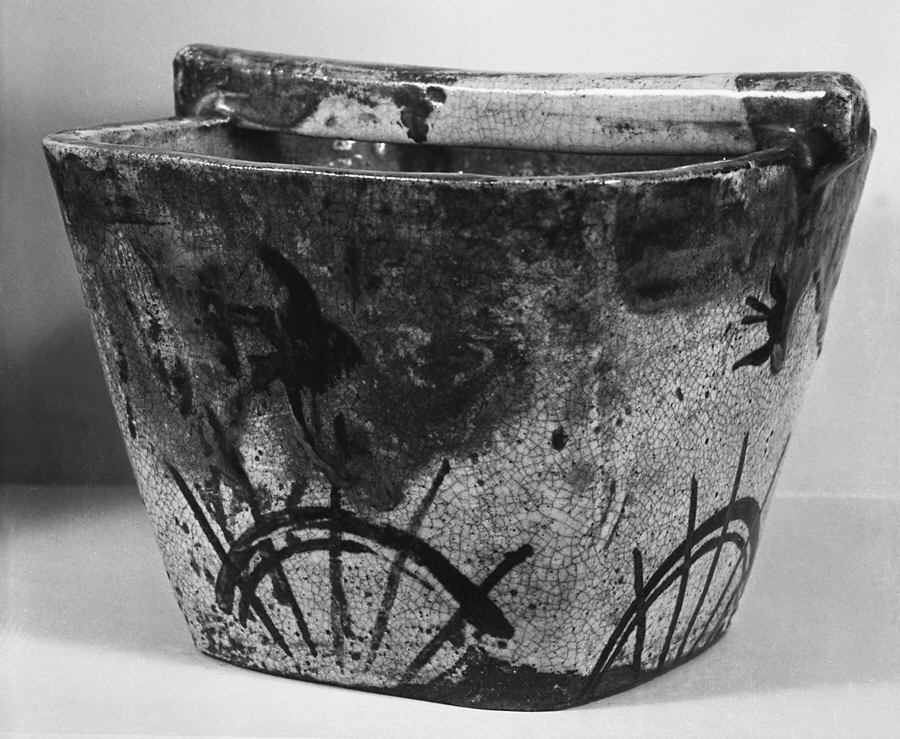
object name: jar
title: Water Jar in the Shape of a Well Bucket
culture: japanese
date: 1801-1900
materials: stoneware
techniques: glazing